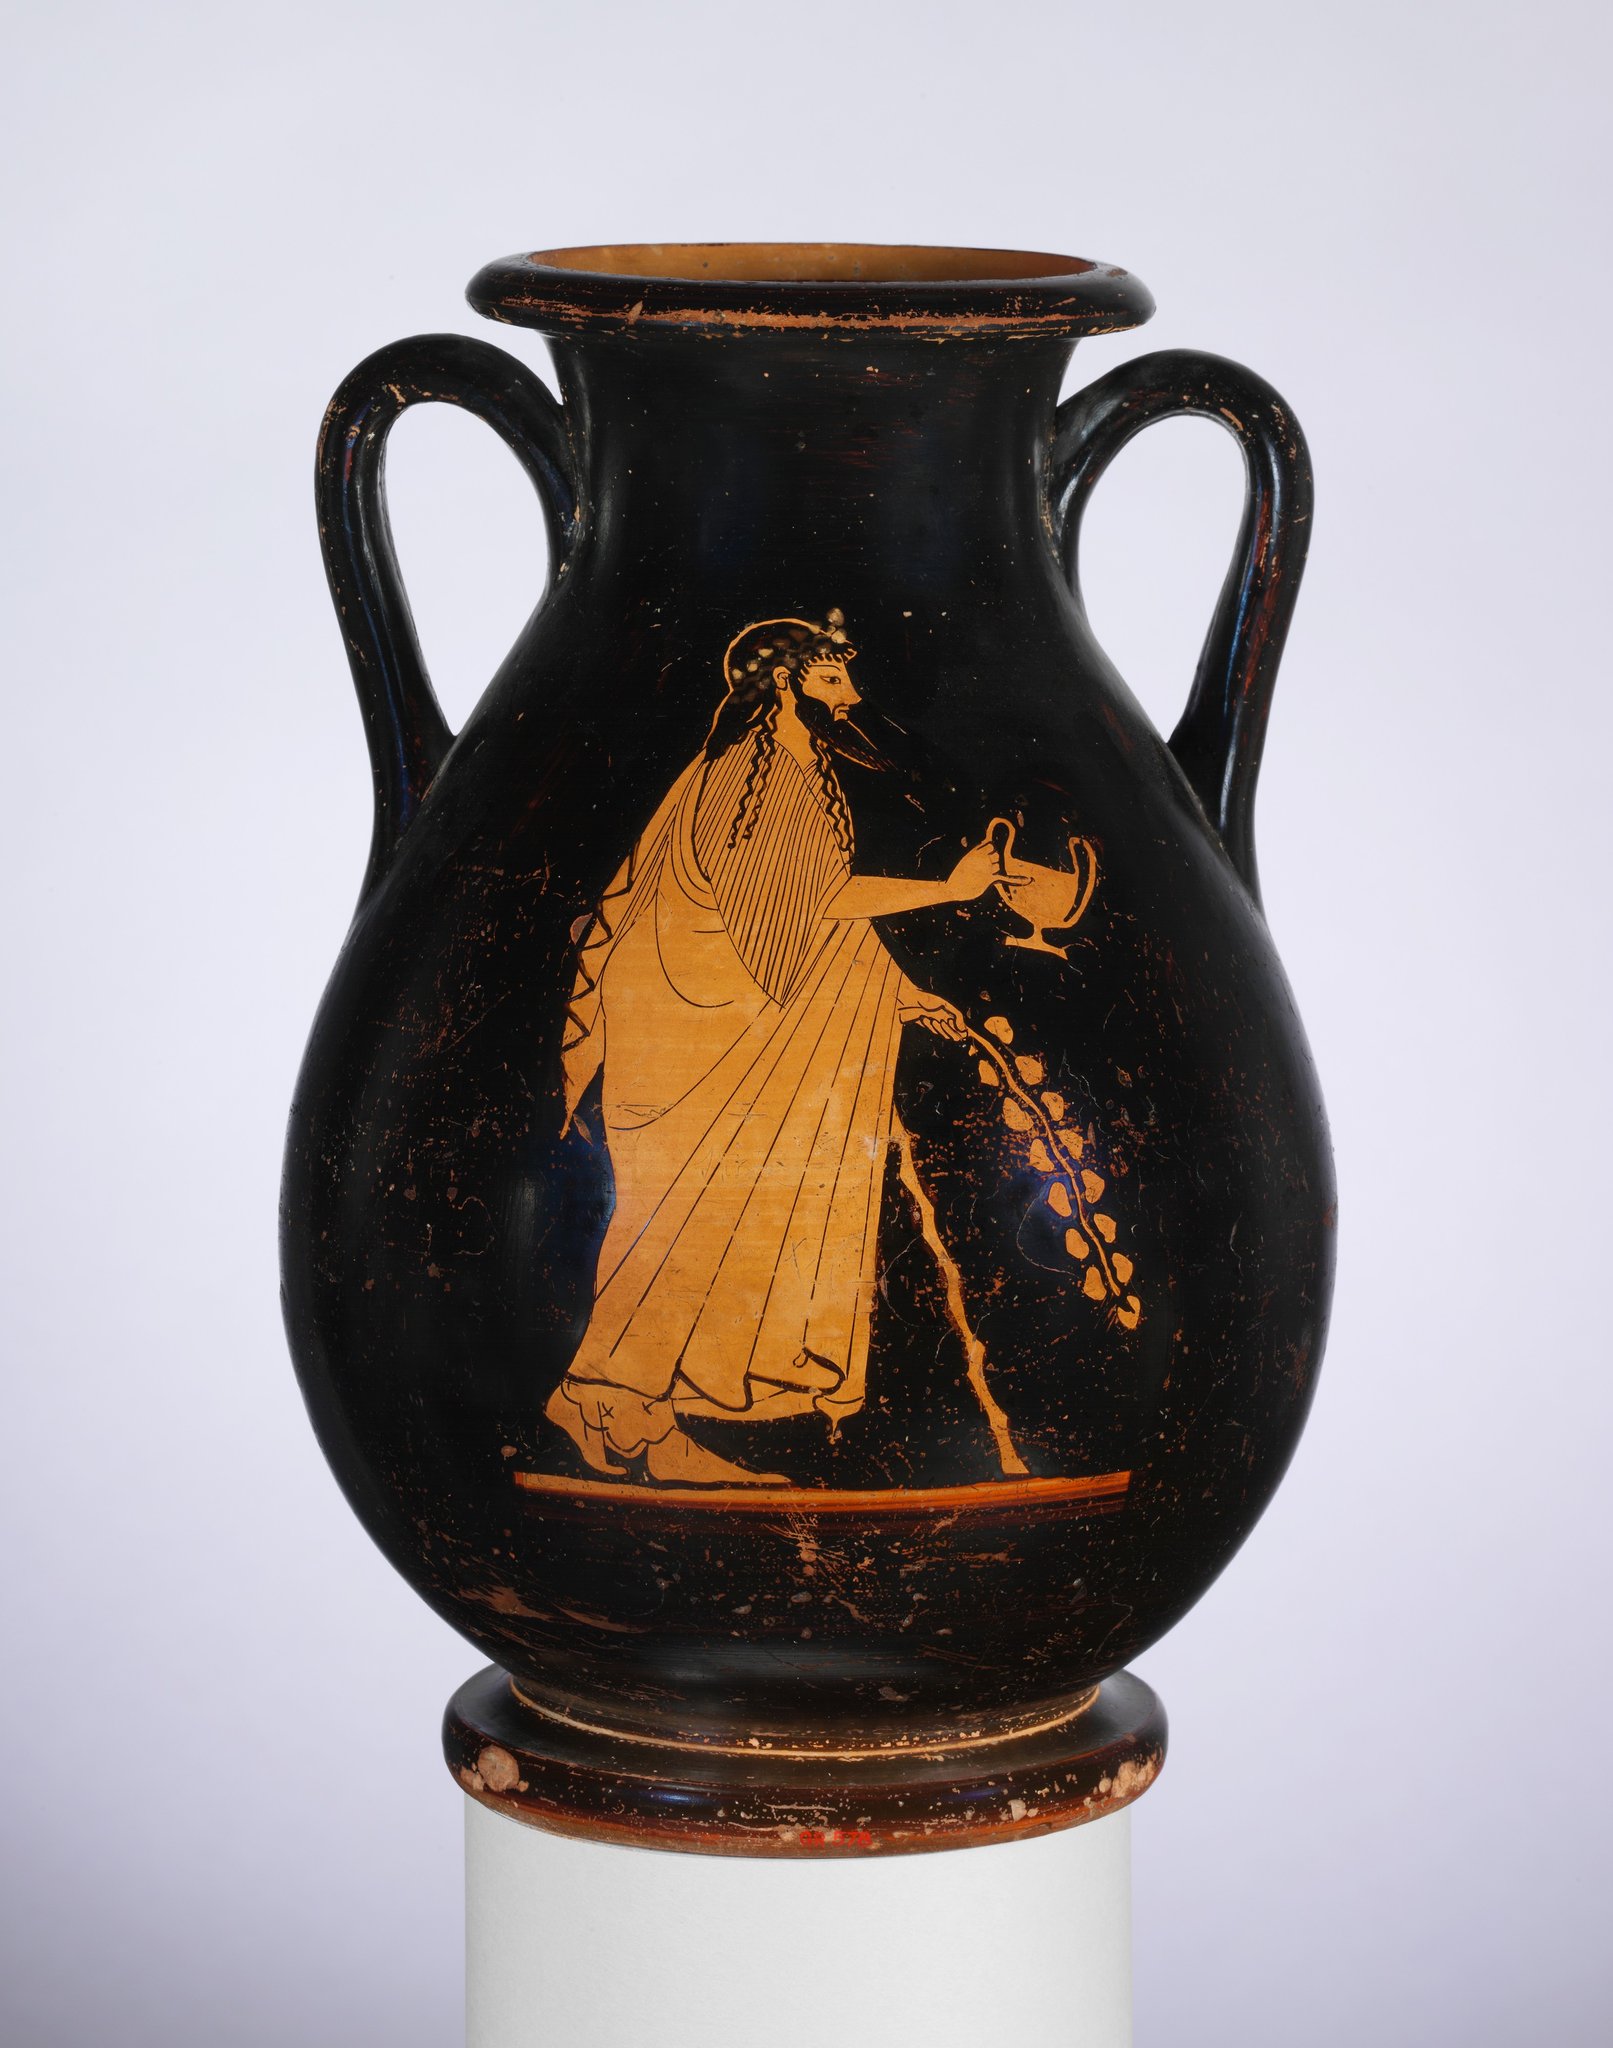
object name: pelike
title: Terracotta pelike (jar)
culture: greek, attic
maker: geras painter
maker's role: artist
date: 480 BCE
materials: terracotta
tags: dionysus,satyrs